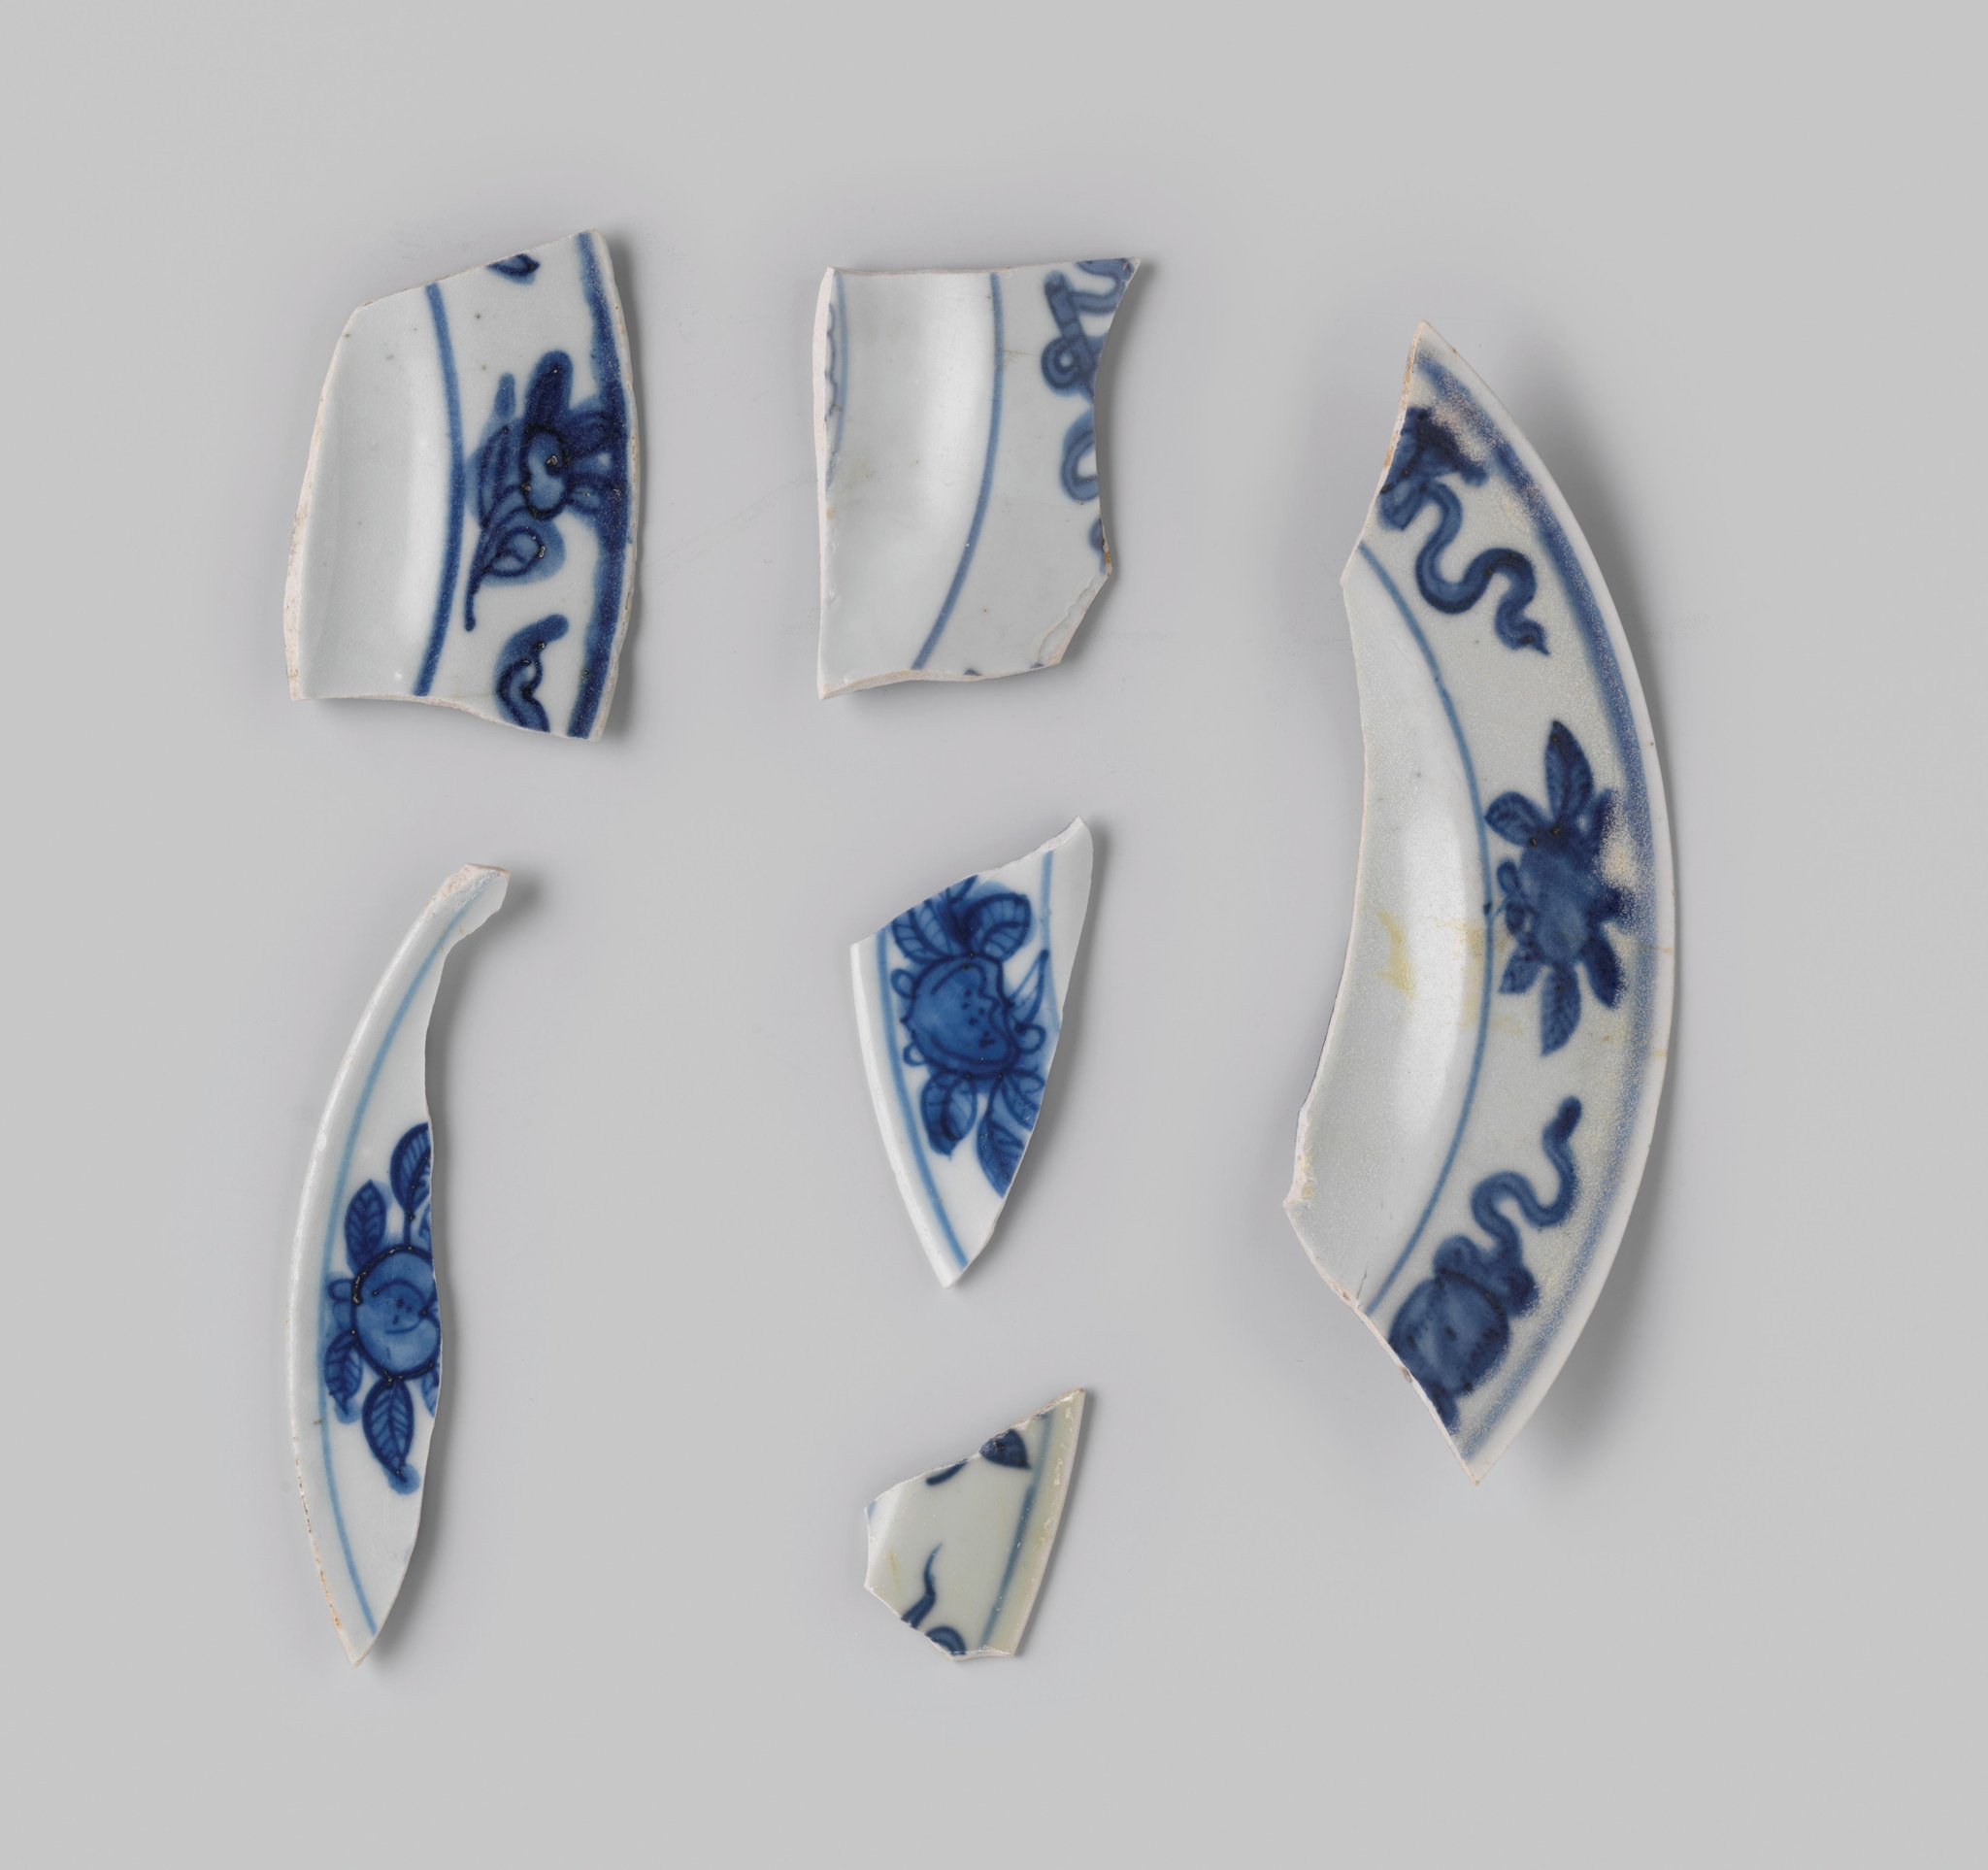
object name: plate dish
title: Scherven van borden uit V.O.C.-schip de 'Witte Leeuw'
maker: Anonymous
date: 1613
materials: porcelain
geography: jingdezhen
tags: verenigde oostindische compagnie, sint-helena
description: A plate with a flattened rim. In the centre a flying crane between clouds. On the rim symbols: lampion, flute and flowers: chrysanthemums. On the outside two stems with flowers, on the lip-rim alternatingly a small flower with stem and a small symbol: a scroll. The whole very sketchily drawn.